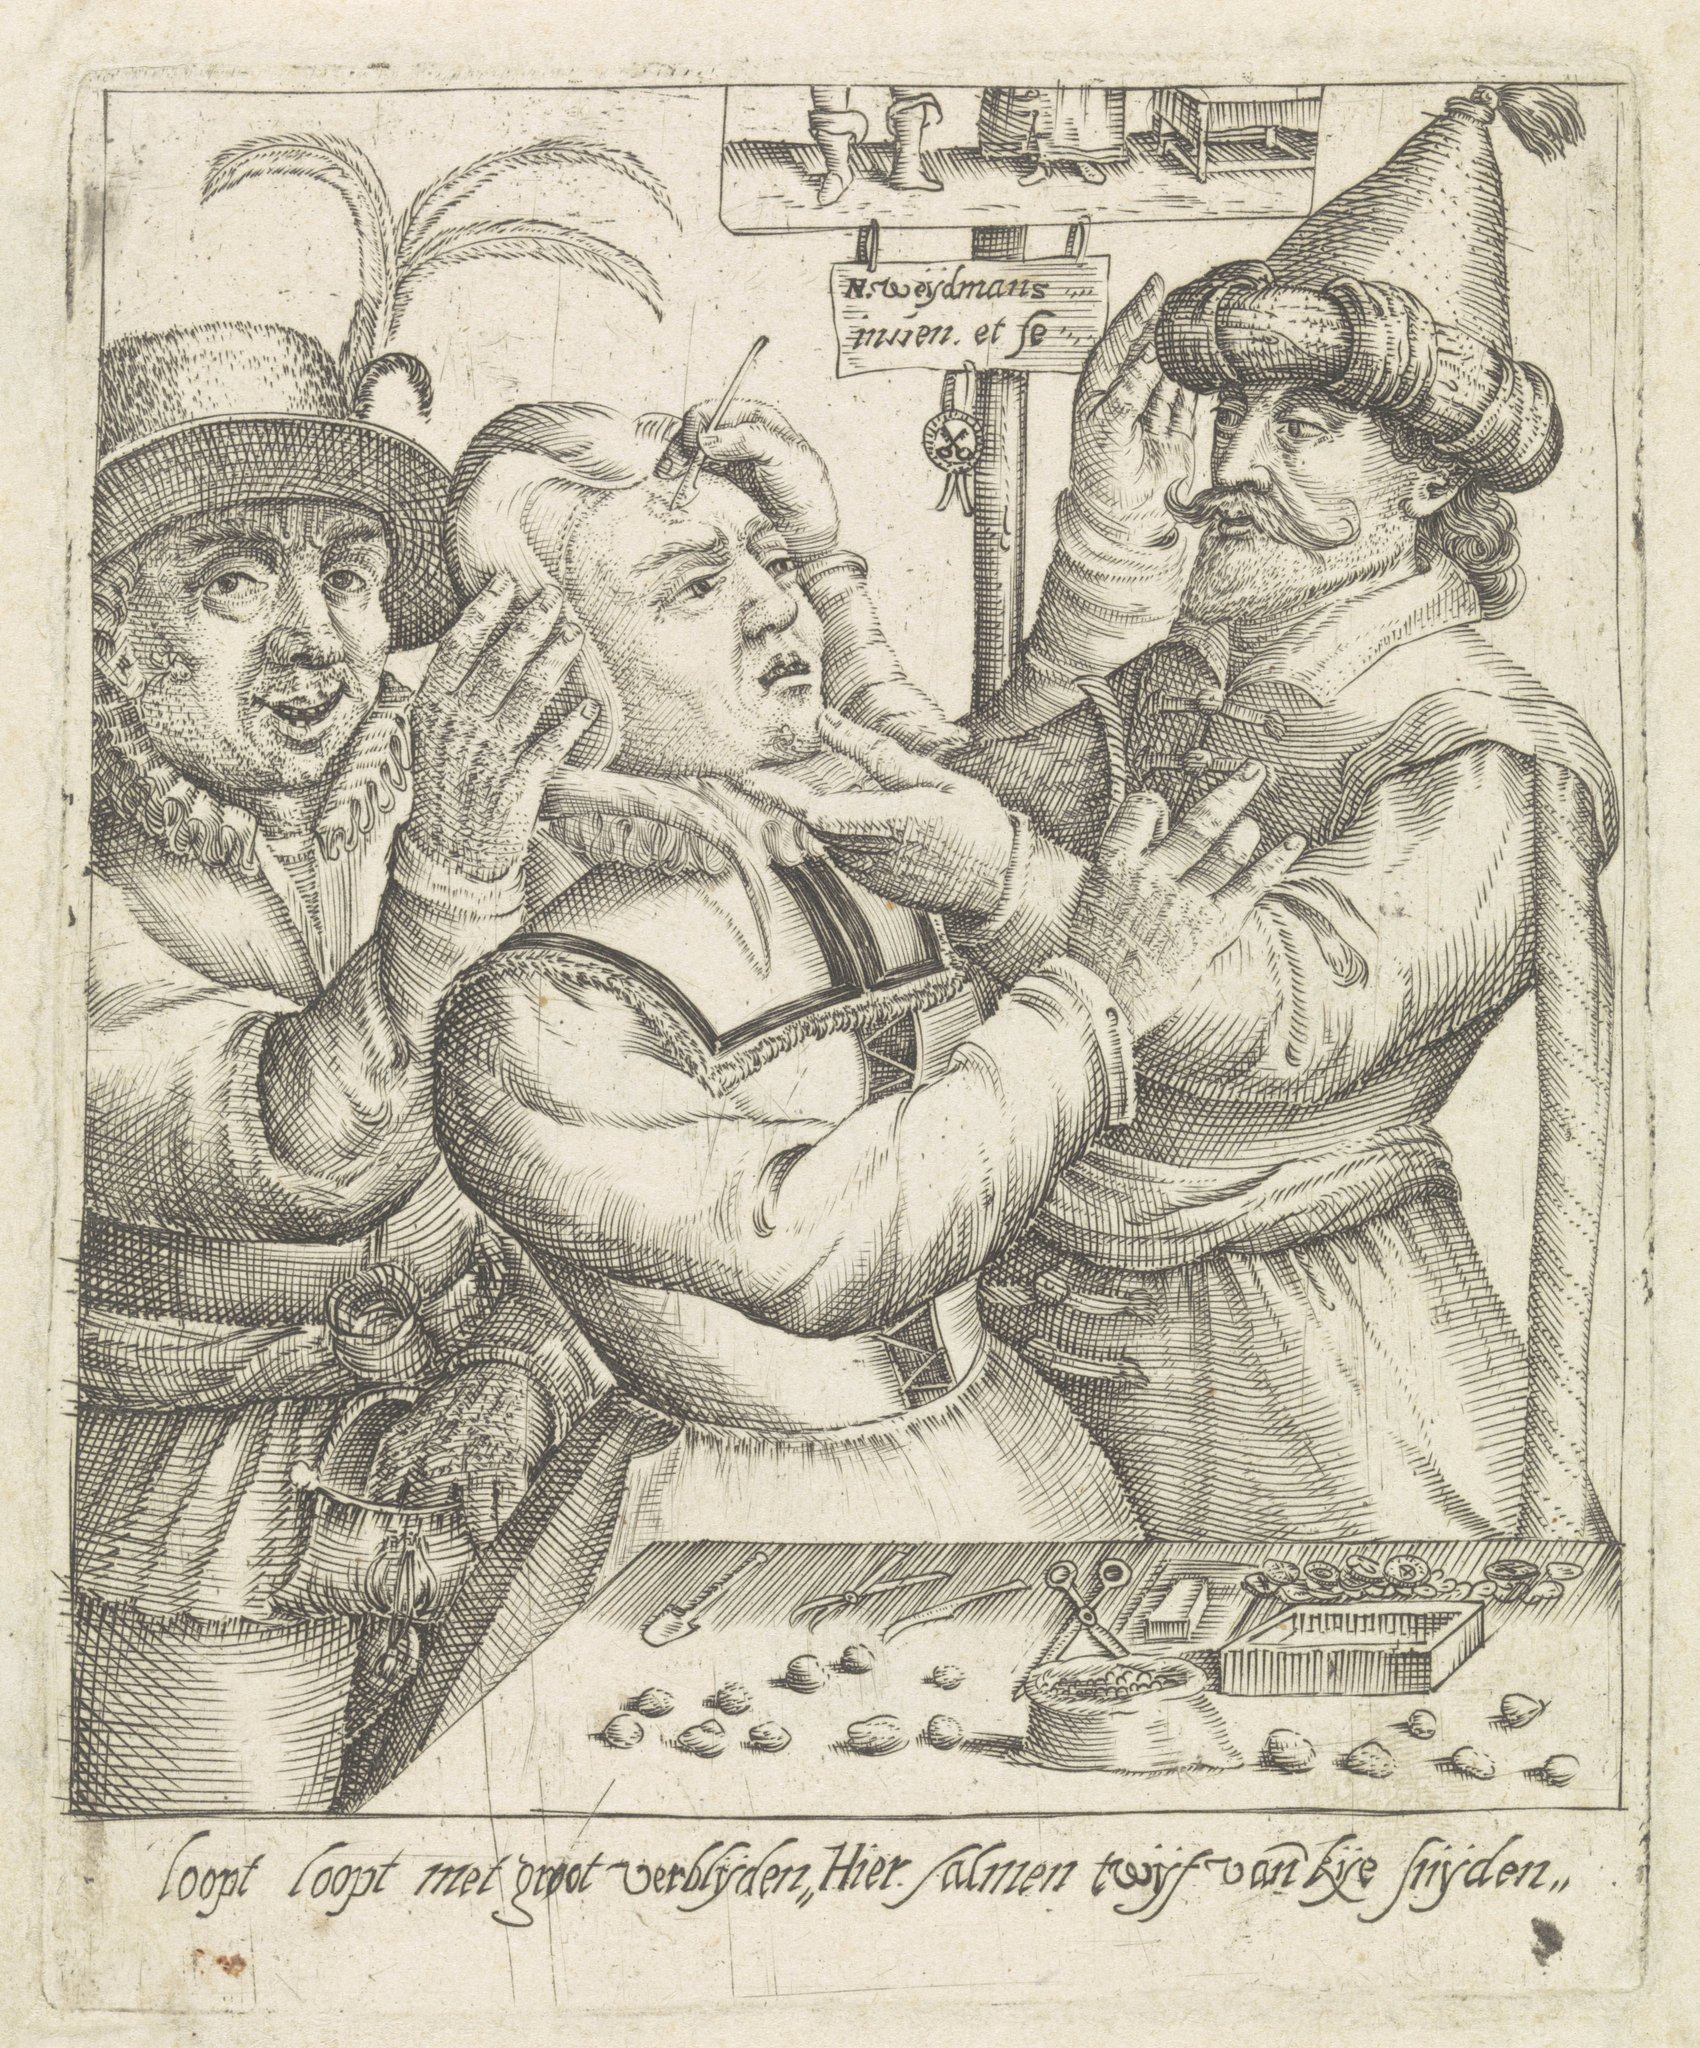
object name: print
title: Keisnijder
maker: nicolaes weydtmans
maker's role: print maker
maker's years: 1570-1642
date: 1580-1642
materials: paper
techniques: engraving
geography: netherlands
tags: stone-operation, e.g.: by the witch of malleghem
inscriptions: collector's mark: Lugt 2228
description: Het snijden van de kei. Een kwakzalver, met tulband op het hoofd, bekrast met een scalpel het voorhoofd van een vrouw. De man achter de vrouw houdt haar hoofd vast en tast in zijn buidel. Op tafel liggen instrumenten en keien. Aan het bord op de achtergrond hangt een zegel met twee sleutels, wellicht het wapen van de stad Leiden. Onderaan een tekstregel in het Nederlands.